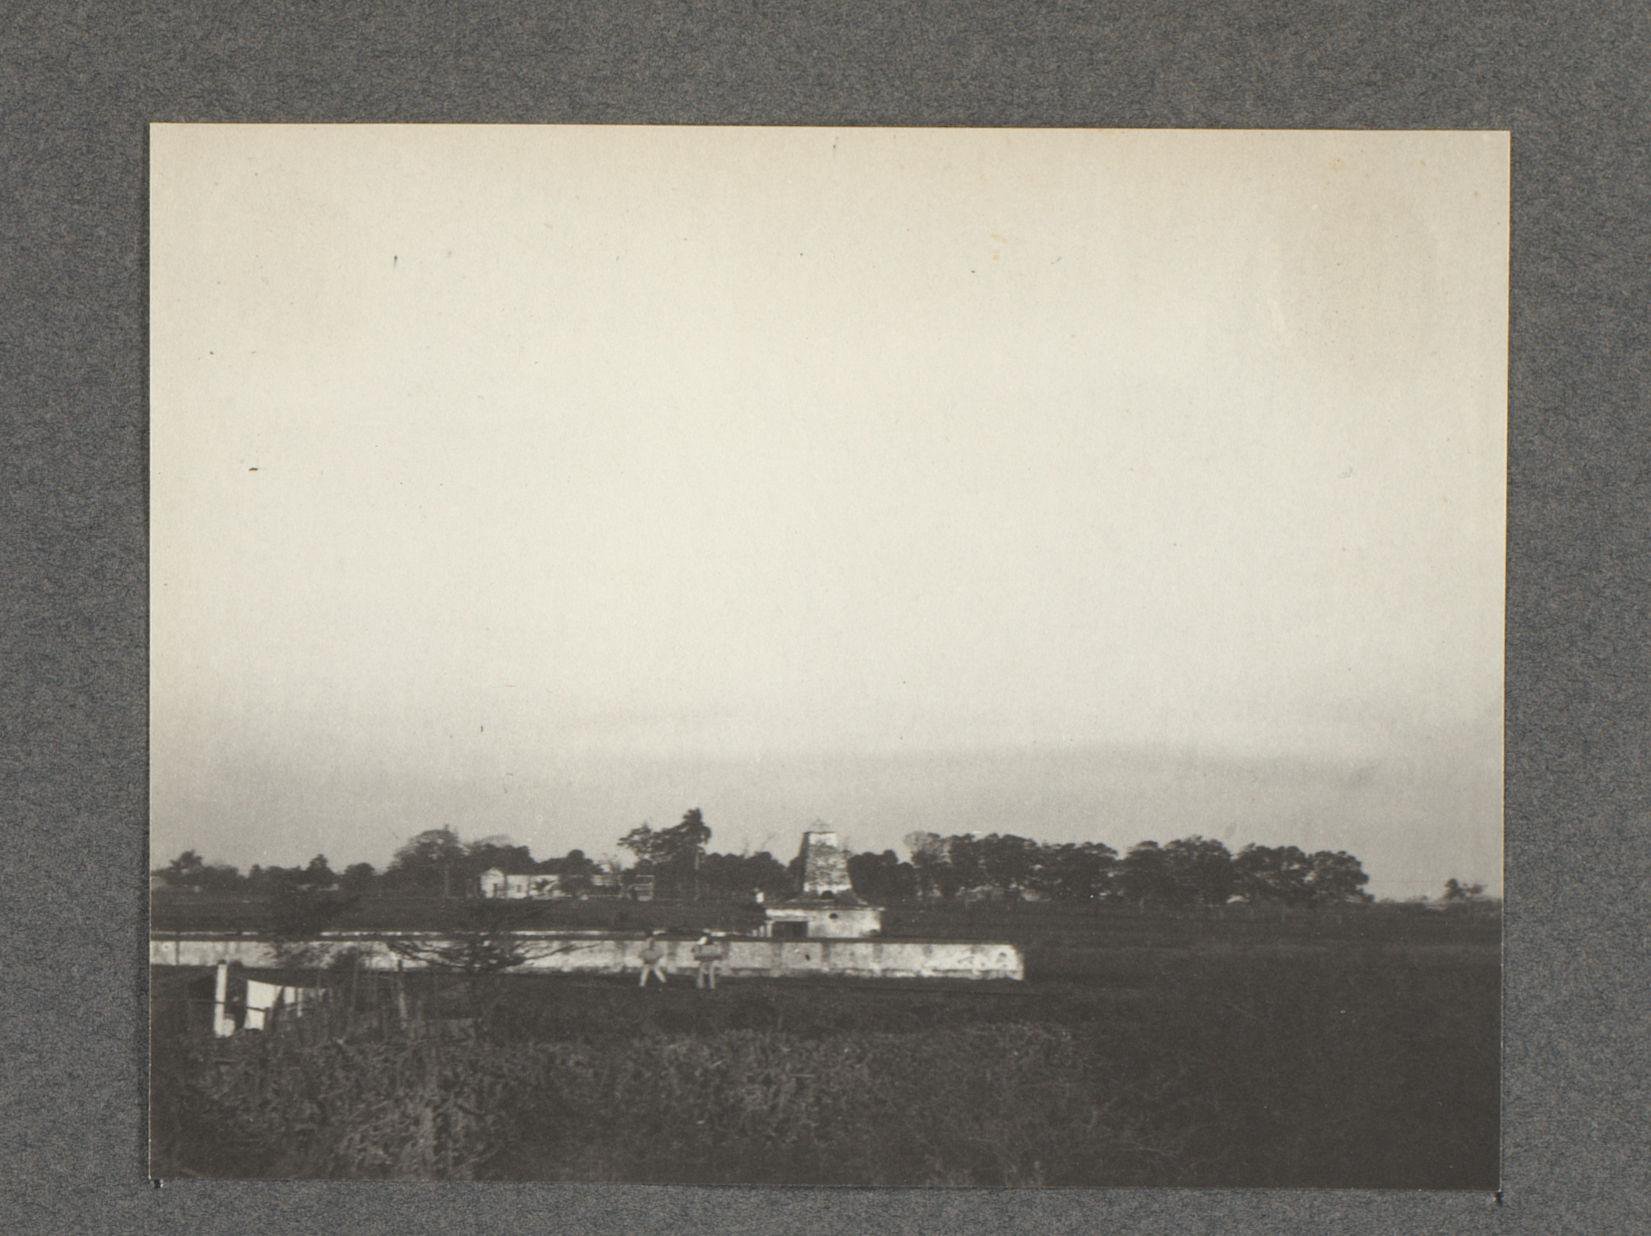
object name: album leaf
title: Gezicht op Matanzas Fort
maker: Anonymous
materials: paper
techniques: platinum process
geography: matanzas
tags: fortifications, military engineering